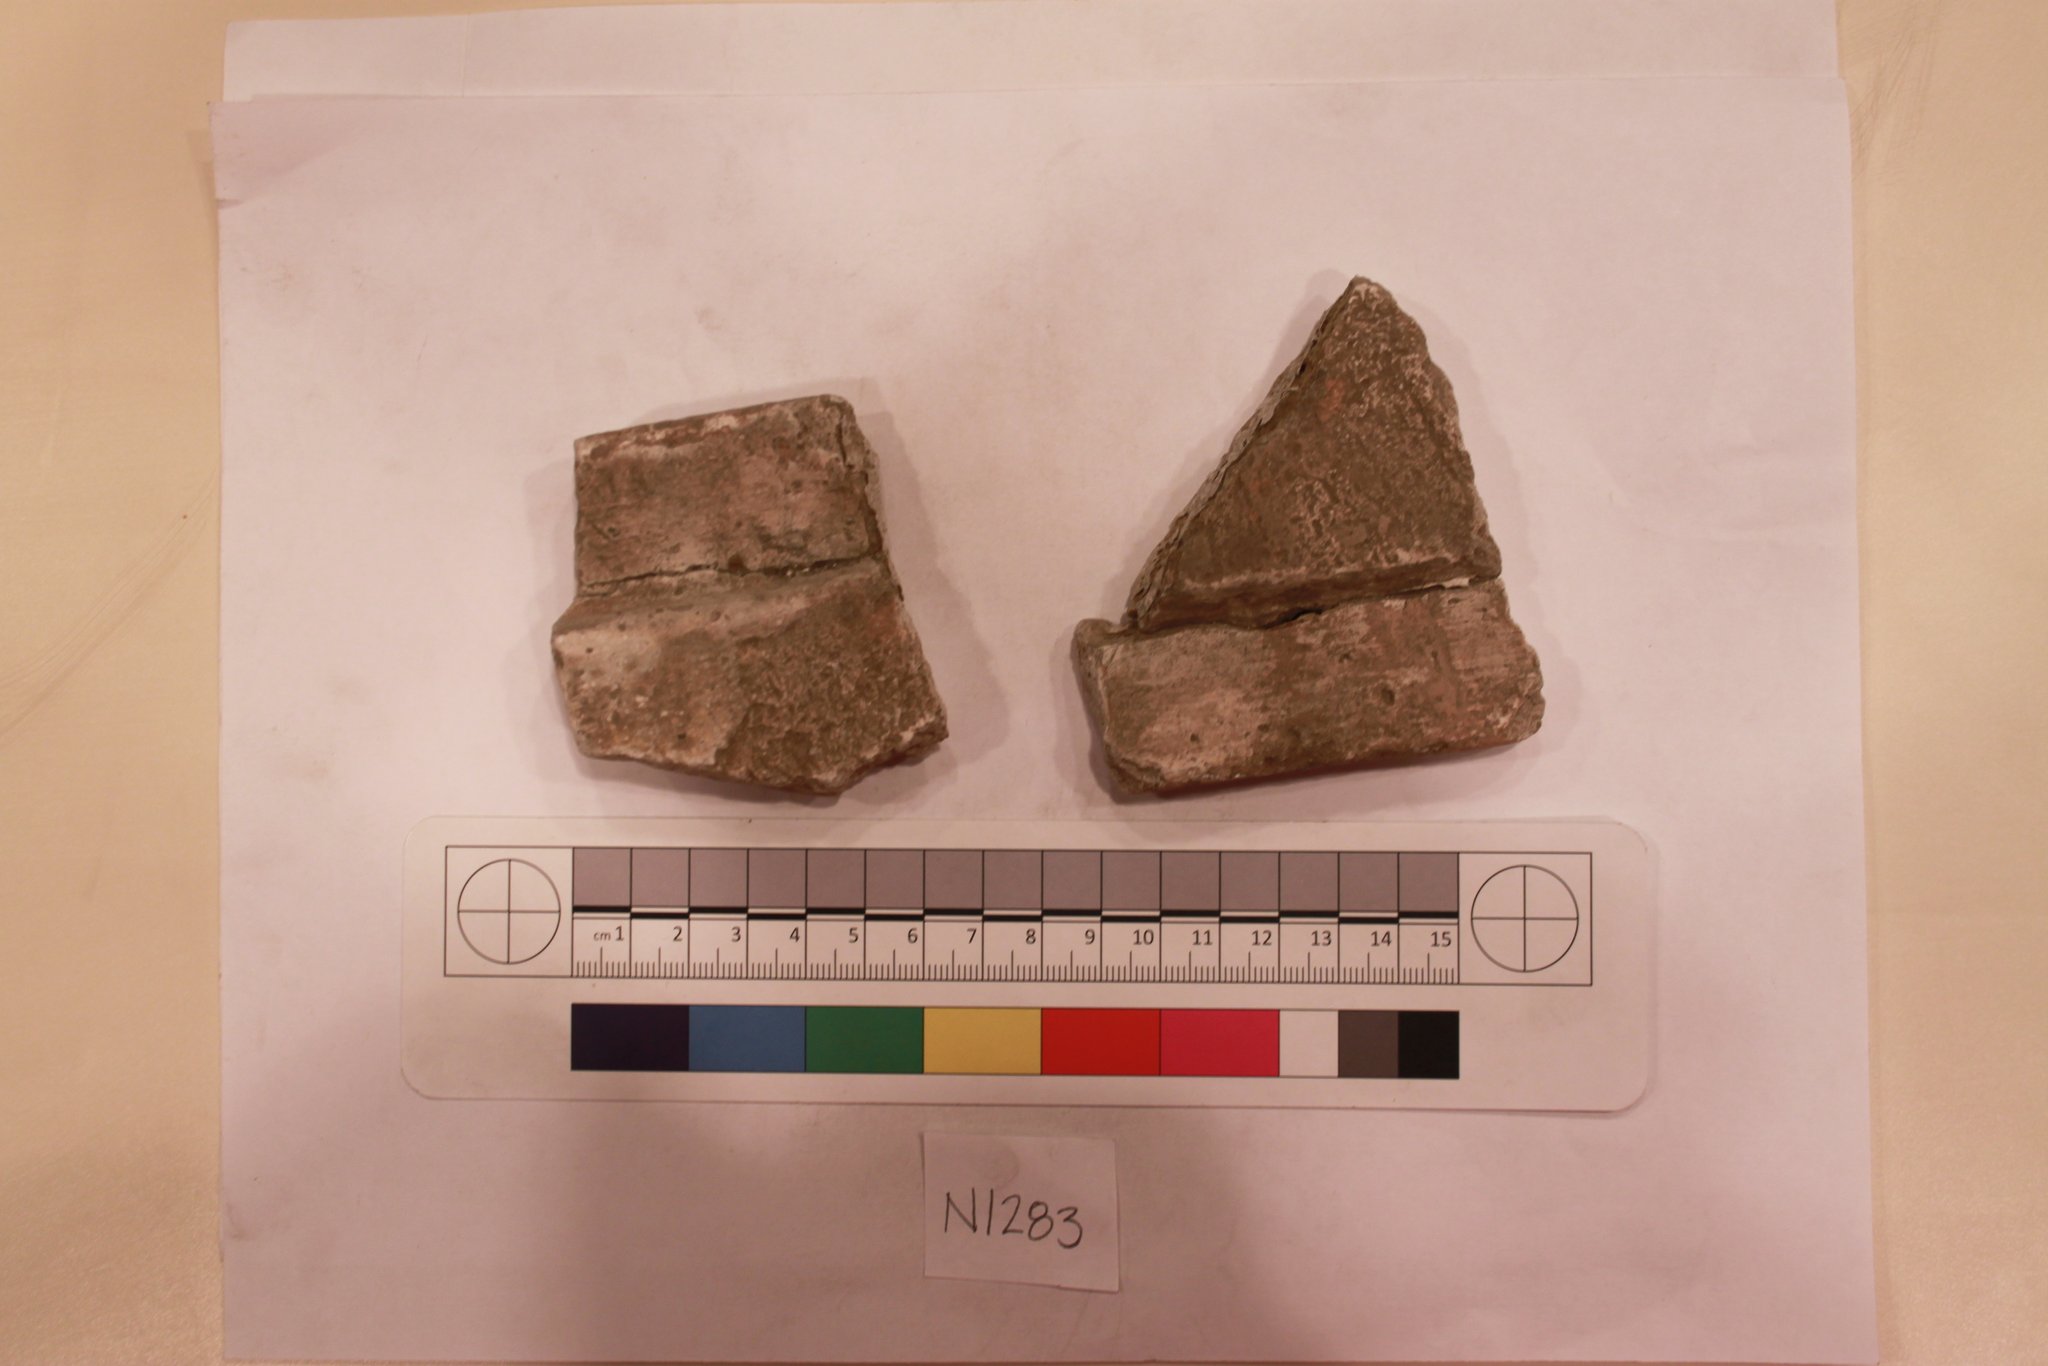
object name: fragment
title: Stucco Fragment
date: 701-1200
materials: plaster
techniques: carving, painting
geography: iran